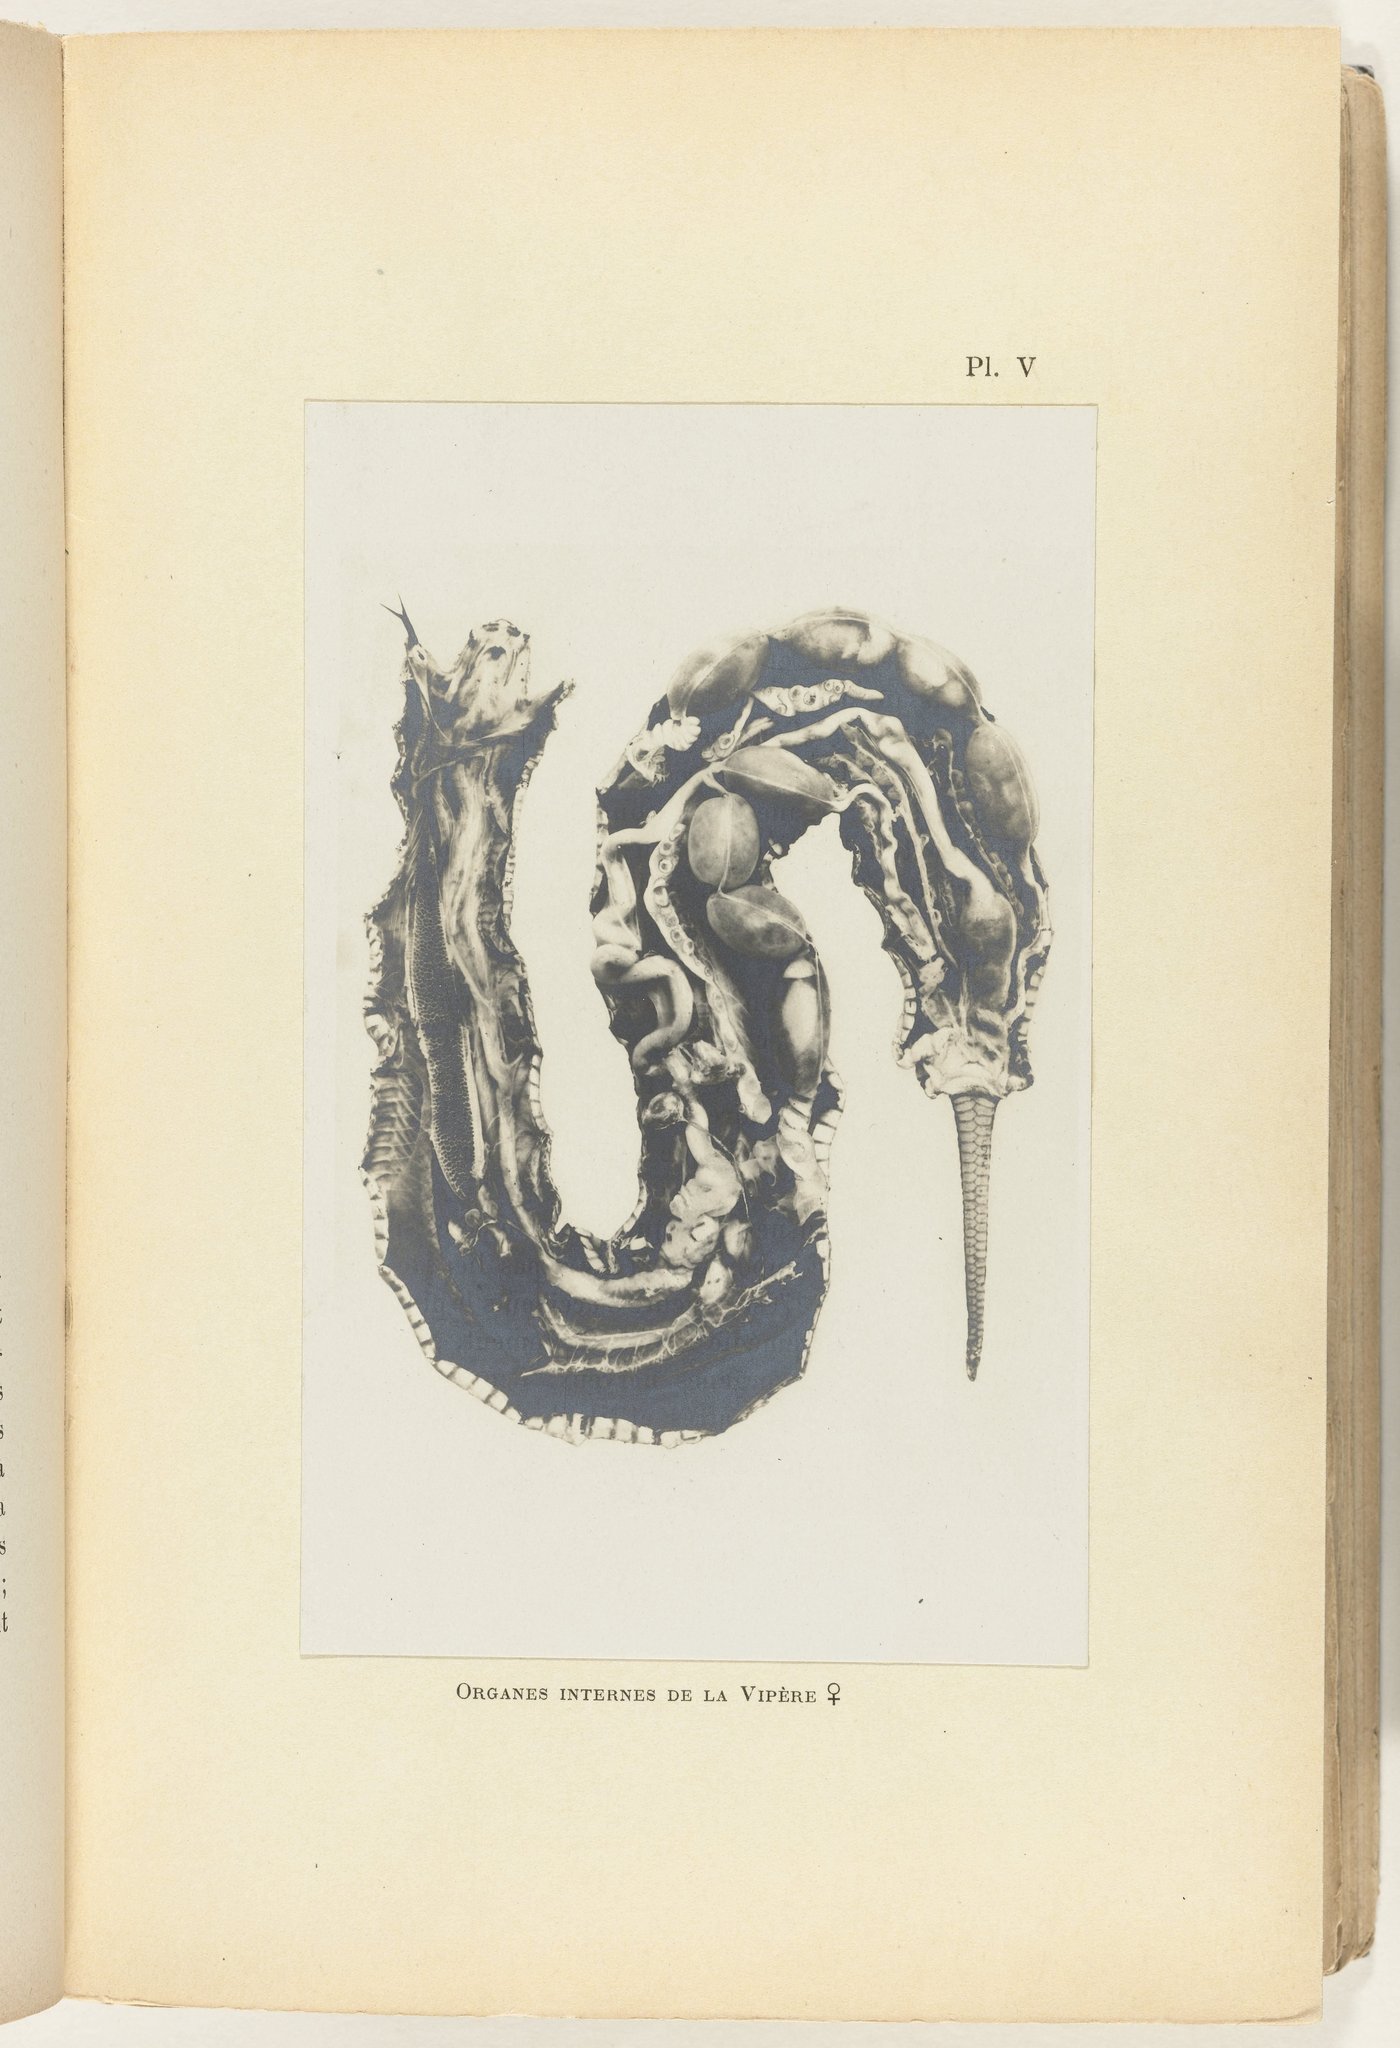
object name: photograph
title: Opengesneden adder met de organen zichtbaar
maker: adolphe louis donnadieu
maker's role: wetenschapper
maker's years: 1840-1911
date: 1891-1901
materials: photographic support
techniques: gelatin silver print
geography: paris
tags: physiology and anatomy, snakes: viper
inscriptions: number: ‘Pl. V’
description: Foto in album 'La photographie des objets immergés', 1901.